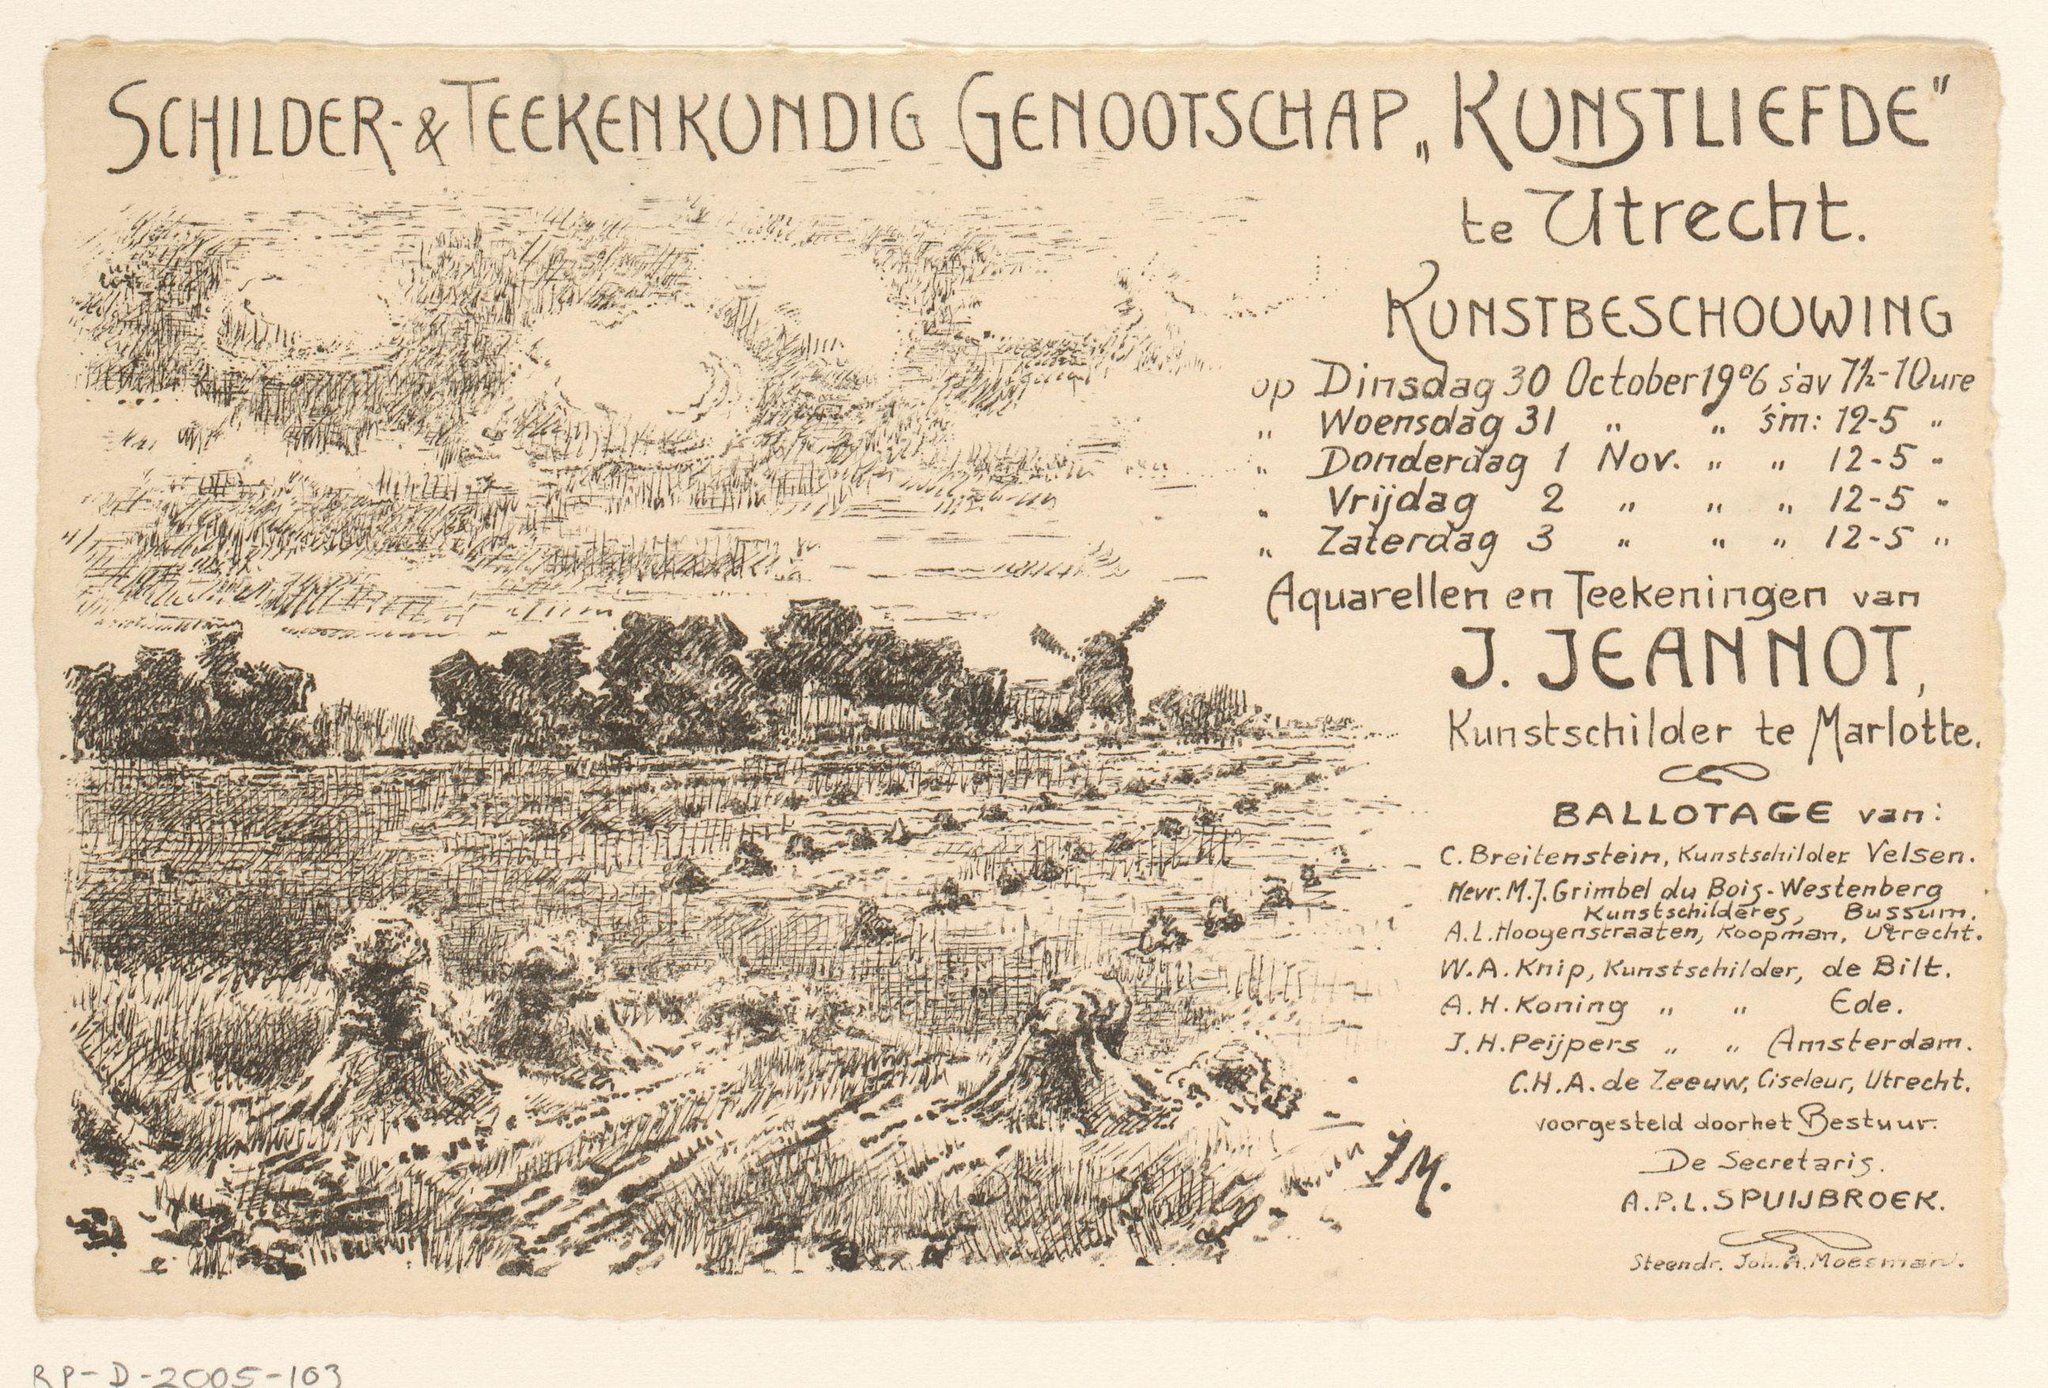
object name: invitation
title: Uitnodiging van Schilder- en Teekenkundig Genootschap "Kunstliefde" voor een kunstbeschouwing van aquarellen en tekeningen van Joseph Jeannot, 30 oktober - 3 november 1906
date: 1906-1910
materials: paper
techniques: lithograph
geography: utrecht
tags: print maker, draughtsman, joseph clément maxime jeannot, criticizing and discussing art, art criticism, circle, club of artists, collecting and exhibiting products of the fine arts, windmill in landscape, sheaf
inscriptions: collector's mark: Lugt 2228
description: Veld met korenschoven en een windmolen. Uitnodiging van Schilder- en Teekenkundig Genootschap "Kunstliefde" voor een kunstbeschouwing van aquarellen en tekeningen van Joseph Jeannot, 30 oktober - 3 november 1906.